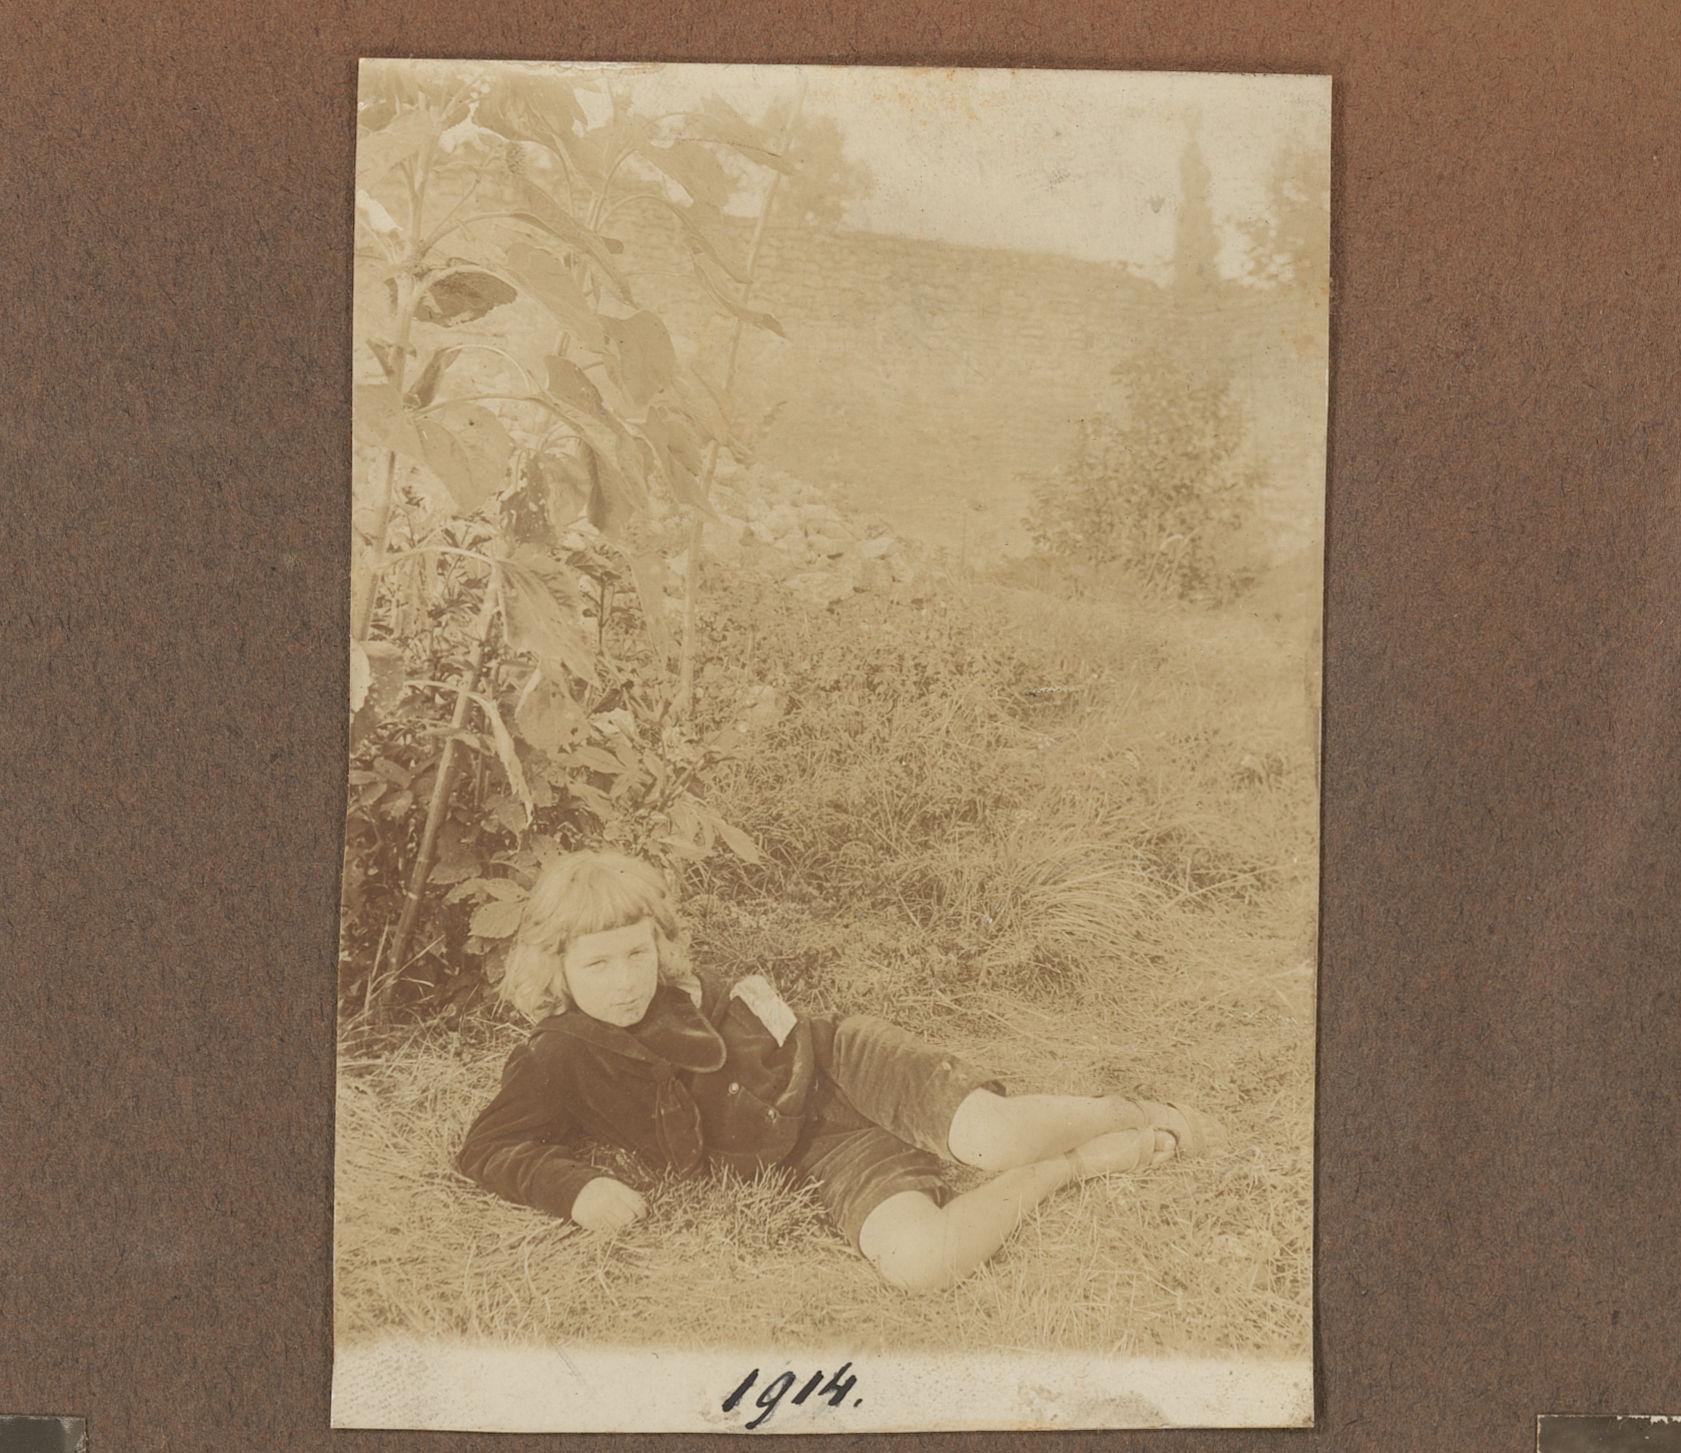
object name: photograph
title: Liggend kind in het gras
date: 1914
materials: photographic support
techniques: photography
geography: netherlands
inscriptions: inscription: ‘1914.’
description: Foto op bruin albumblad 24 van familiealbum van Alphons Diepenbrock.